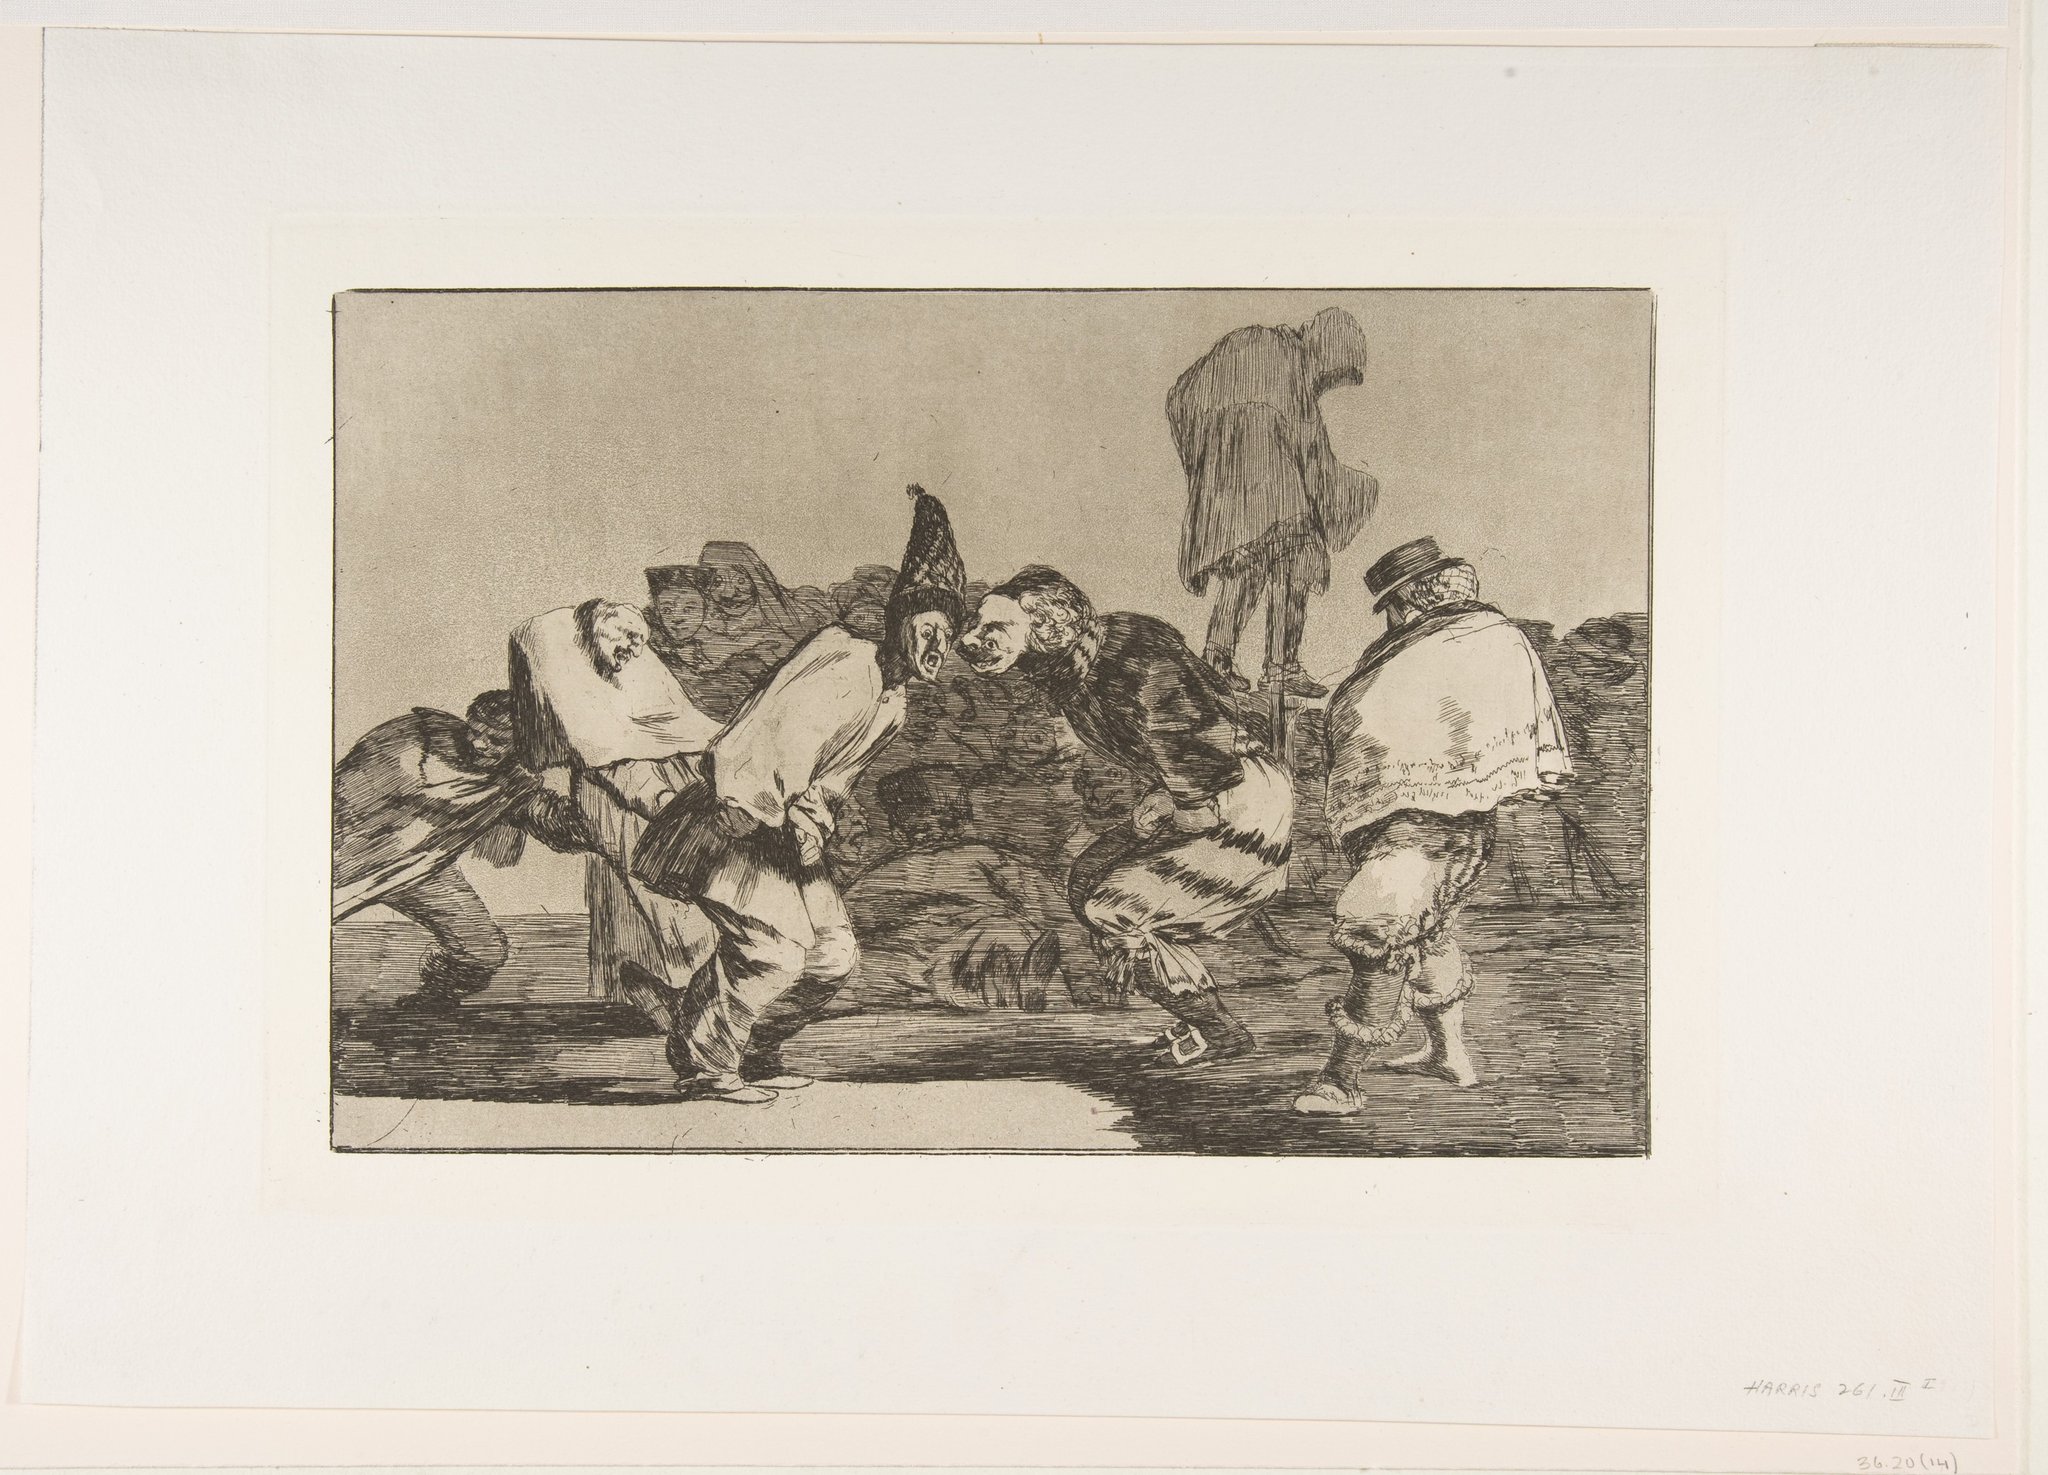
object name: print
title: 'Carnival Folly' from the 'Disparates' (Follies / Irrationalities)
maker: goya (francisco de goya y lucientes)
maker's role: artist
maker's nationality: spanish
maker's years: 1746-1828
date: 1815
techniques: aquatint, etching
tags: human figures